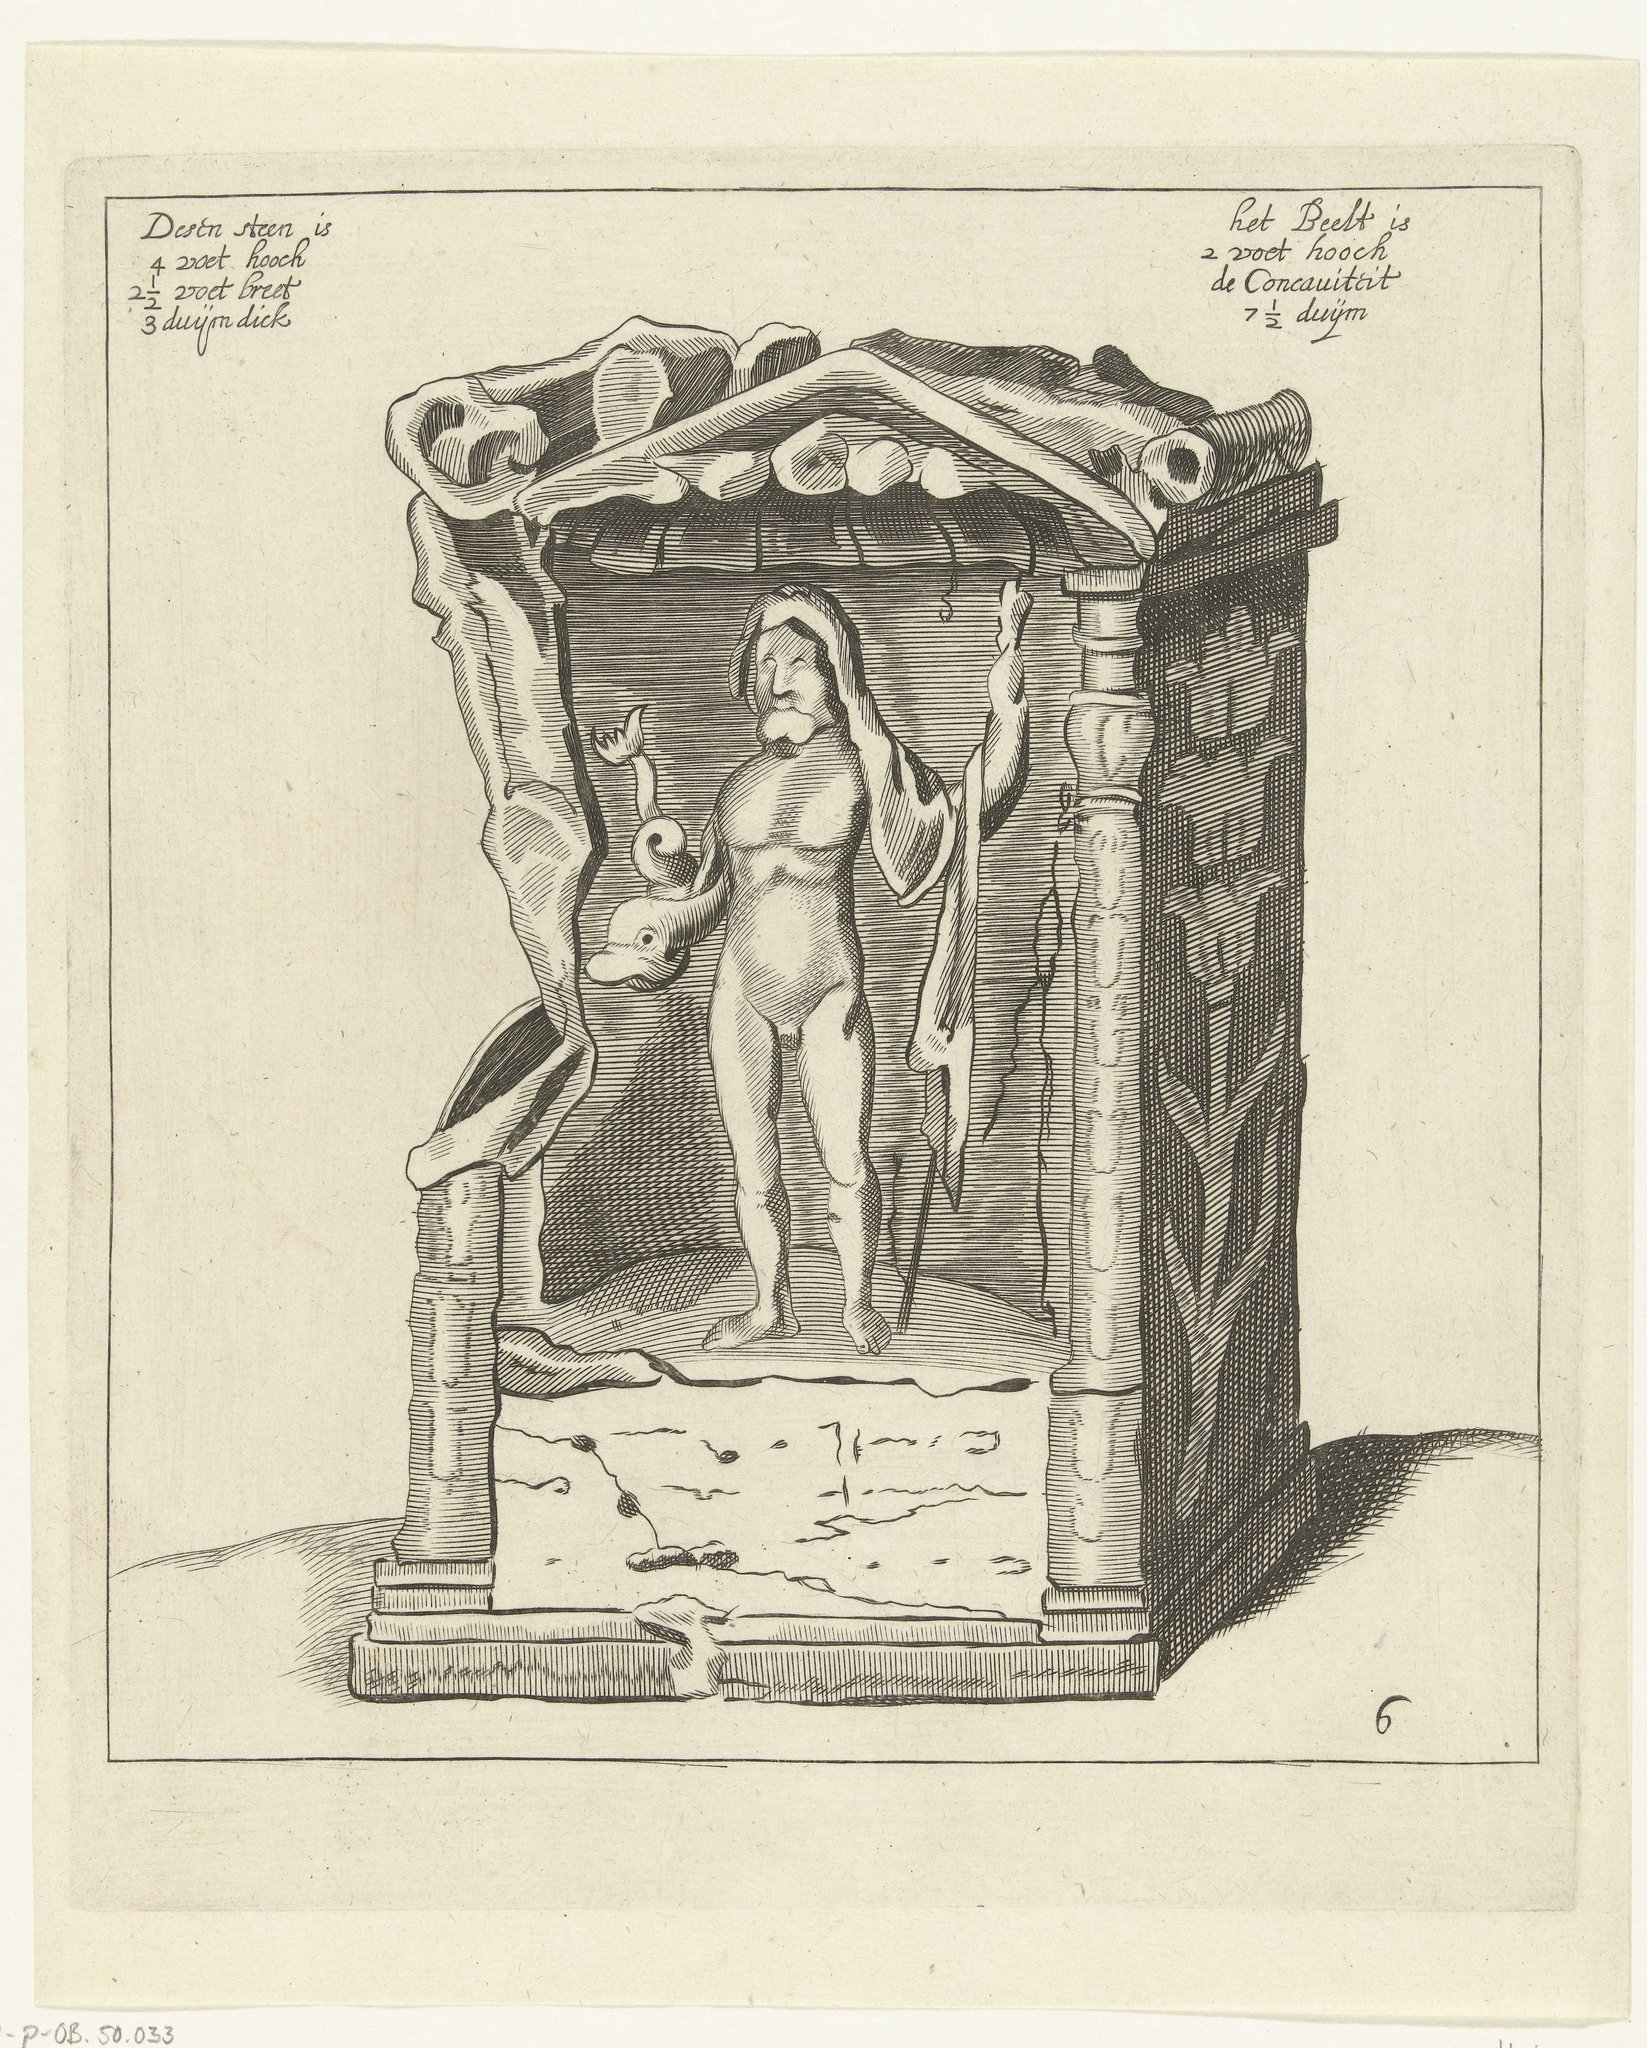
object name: historical object representation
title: Neptunus-altaar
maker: hendrick danckerts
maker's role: print maker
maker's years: 1625-1679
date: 1647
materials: paper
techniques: engraving, etching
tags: (story of) neptune (poseidon)